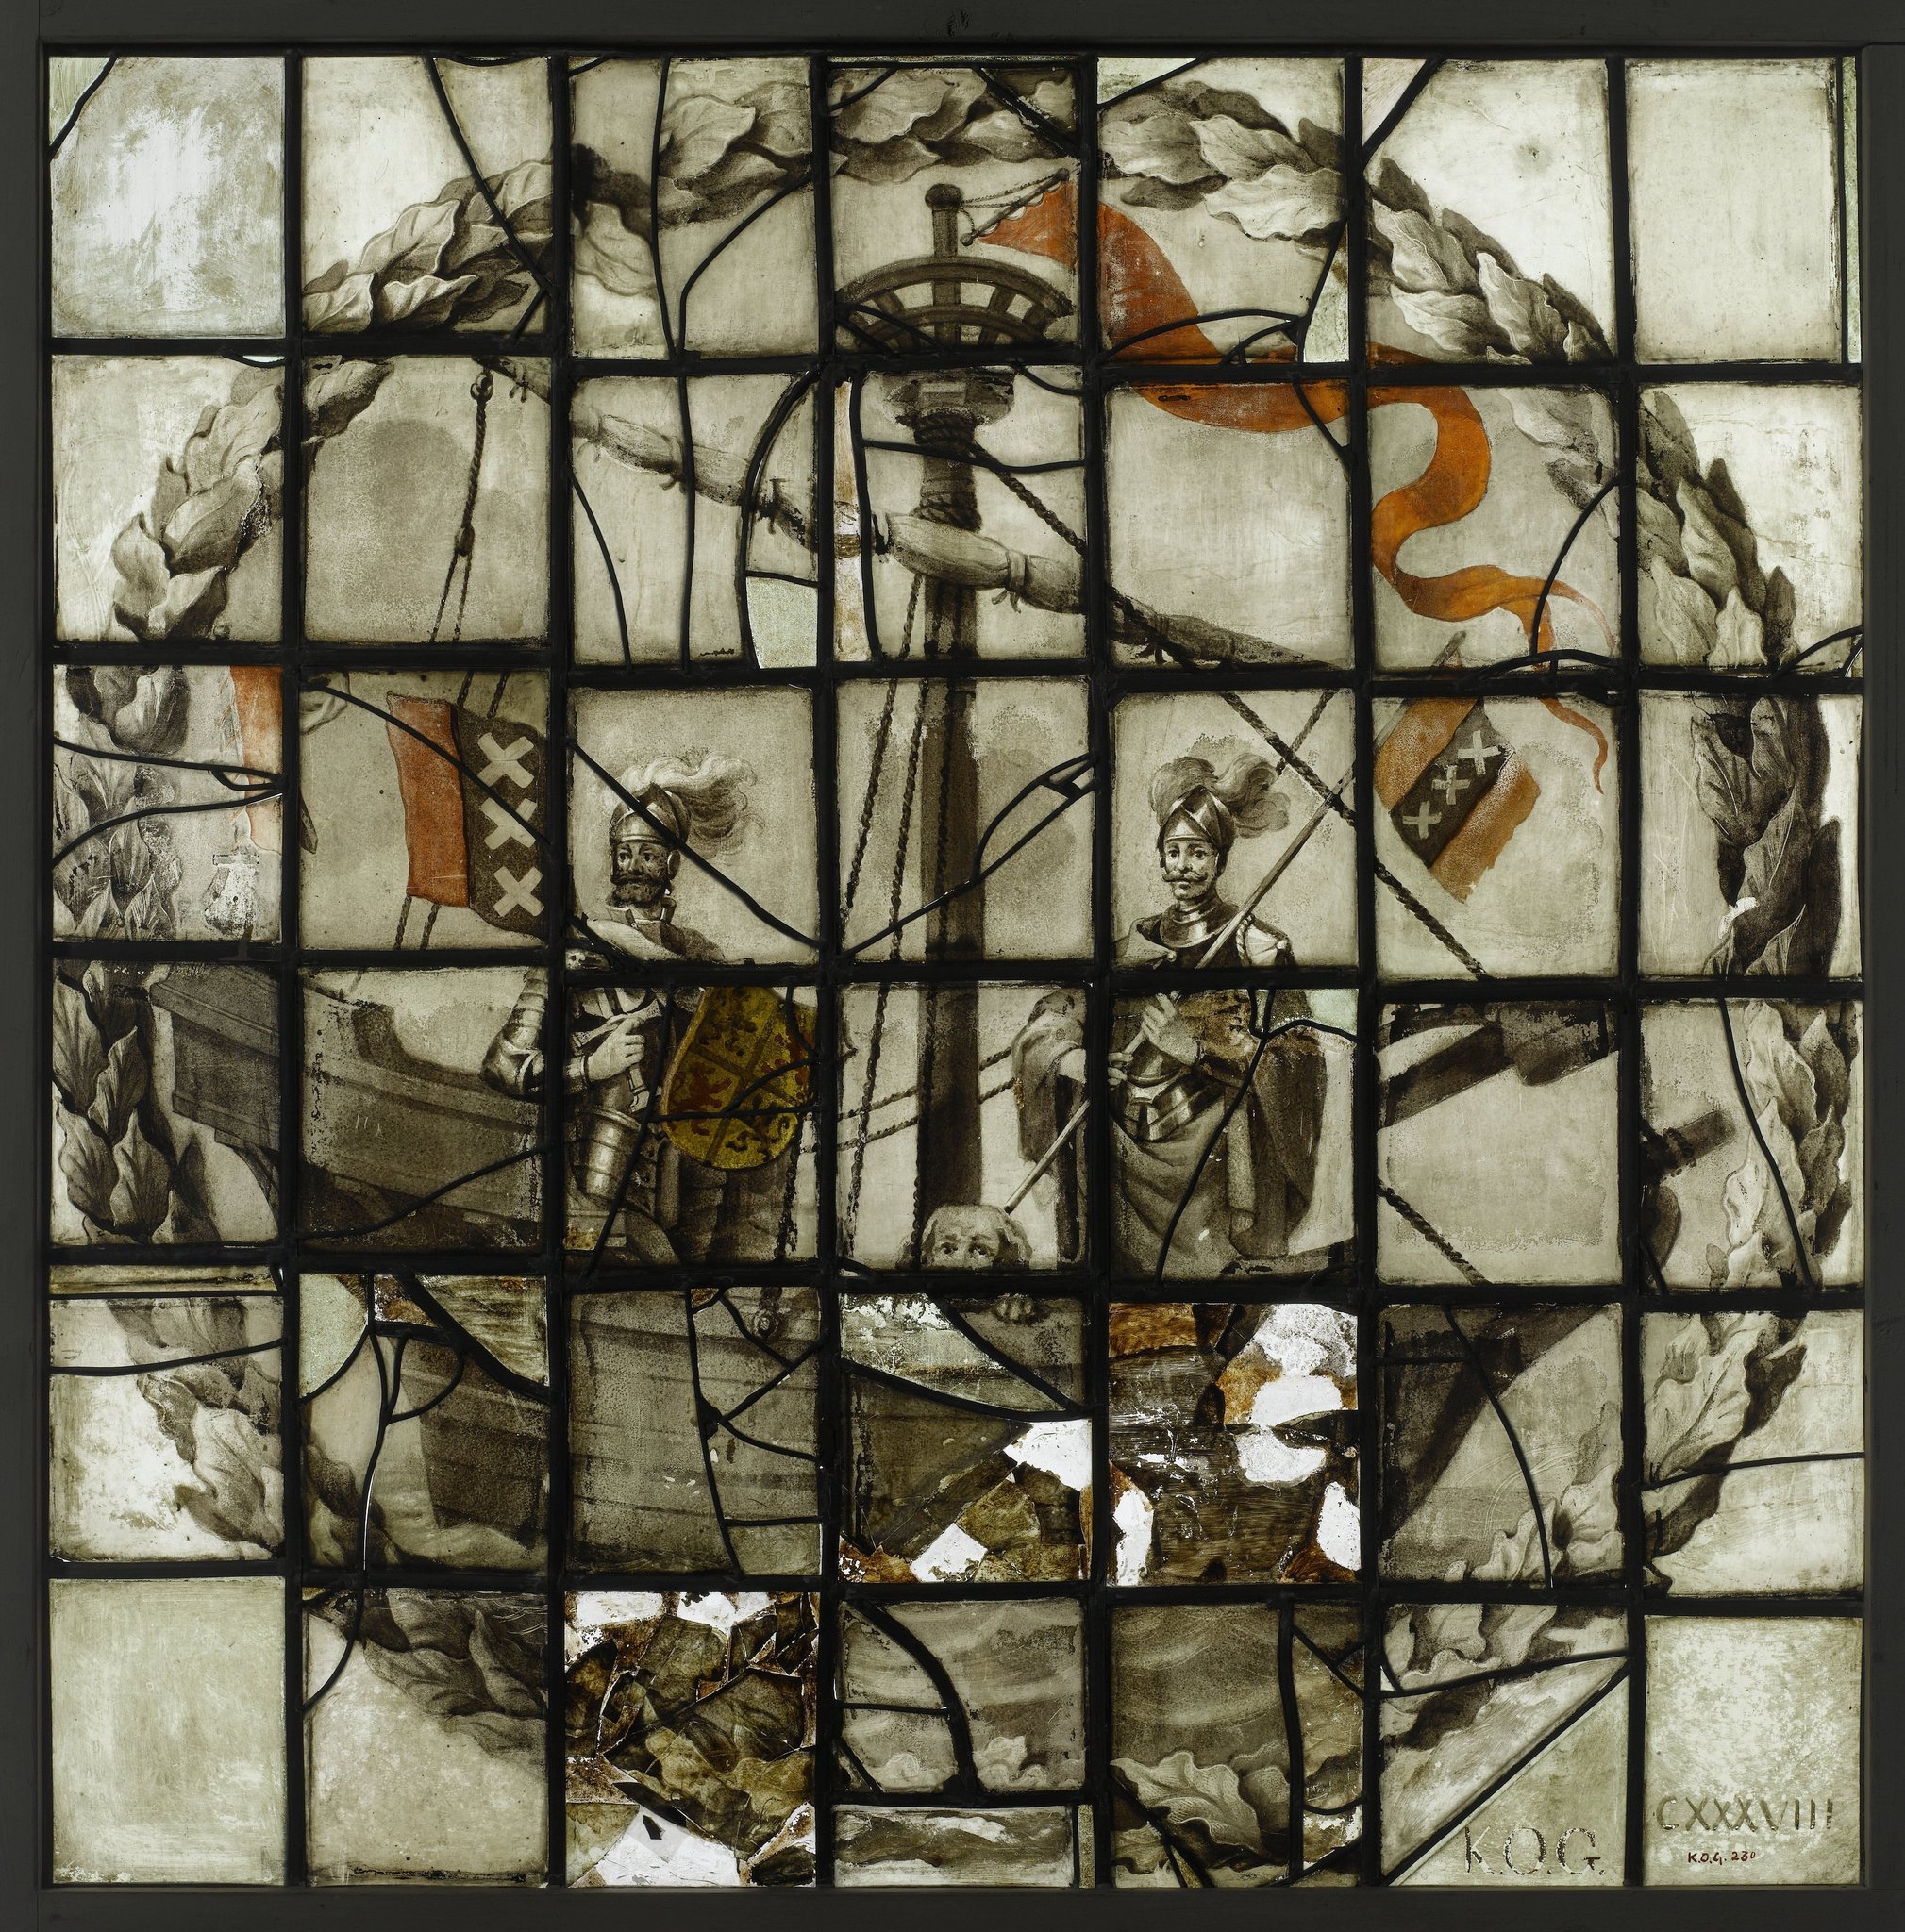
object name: light window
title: Ruit met twee mannen in koggeschip met vlag met wapen Amsterdam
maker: Anonymous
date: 1600-1699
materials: glass, lead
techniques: leading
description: Groot raam met de afbeelding van twee mannen staande in het koggeschip. Eén draagt de vlag met het wapen van Amsterdam. Opmerking: Heeft dezelfde afbeelding als inv. nr. BK-KOG-232. Behoort tot de serie: BK-KOG-229 t/m 232.